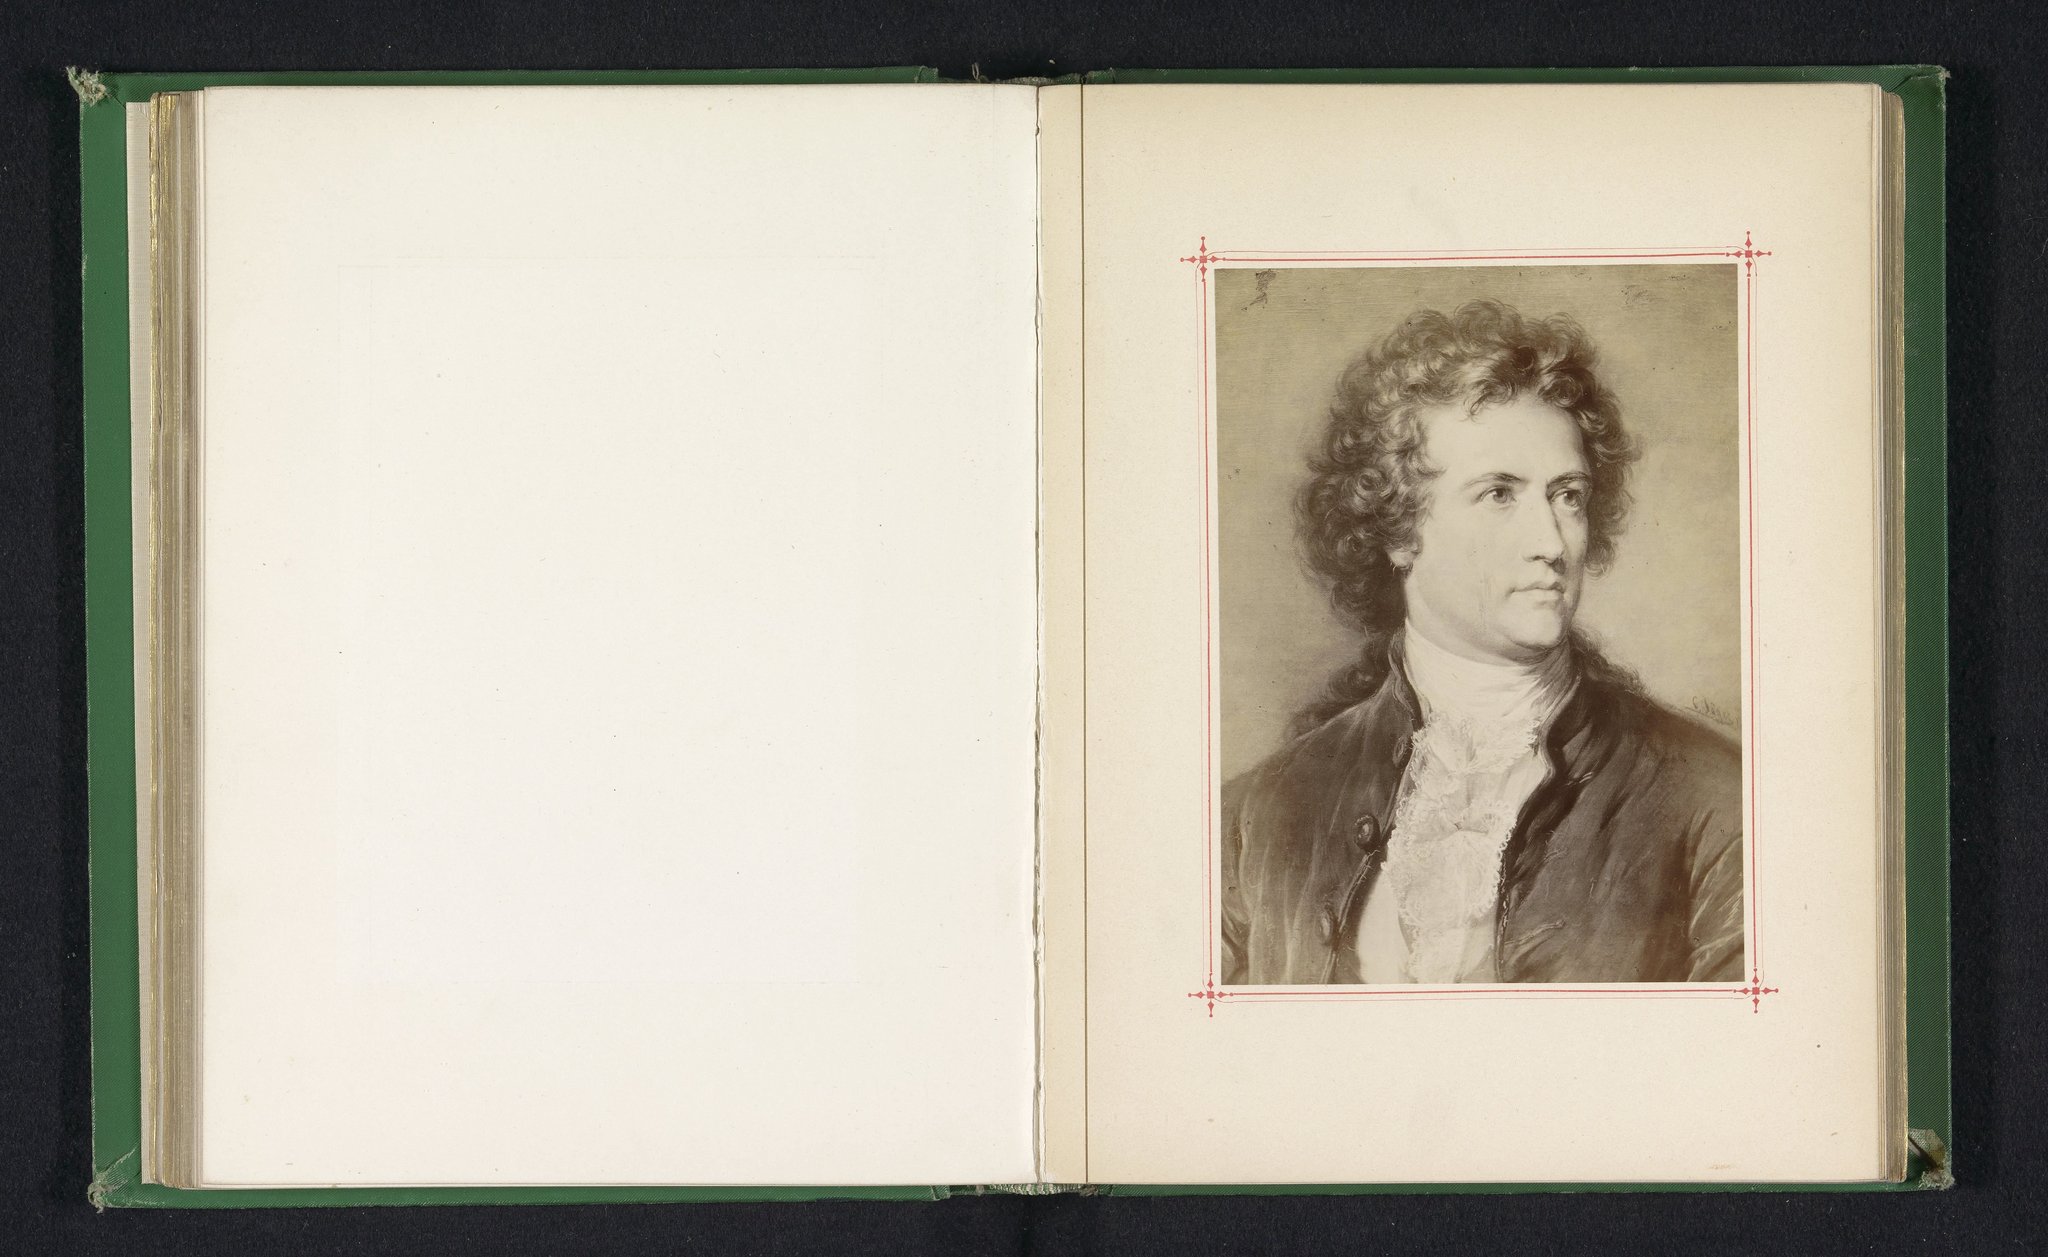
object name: photograph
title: Fotoreproductie van een portret van Johann Wolfgang von Goethe door Carl Jäger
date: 1868-1878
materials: photographic support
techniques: albumen print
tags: draughtsman, johann wolfgang von goethe, writer, poet, author